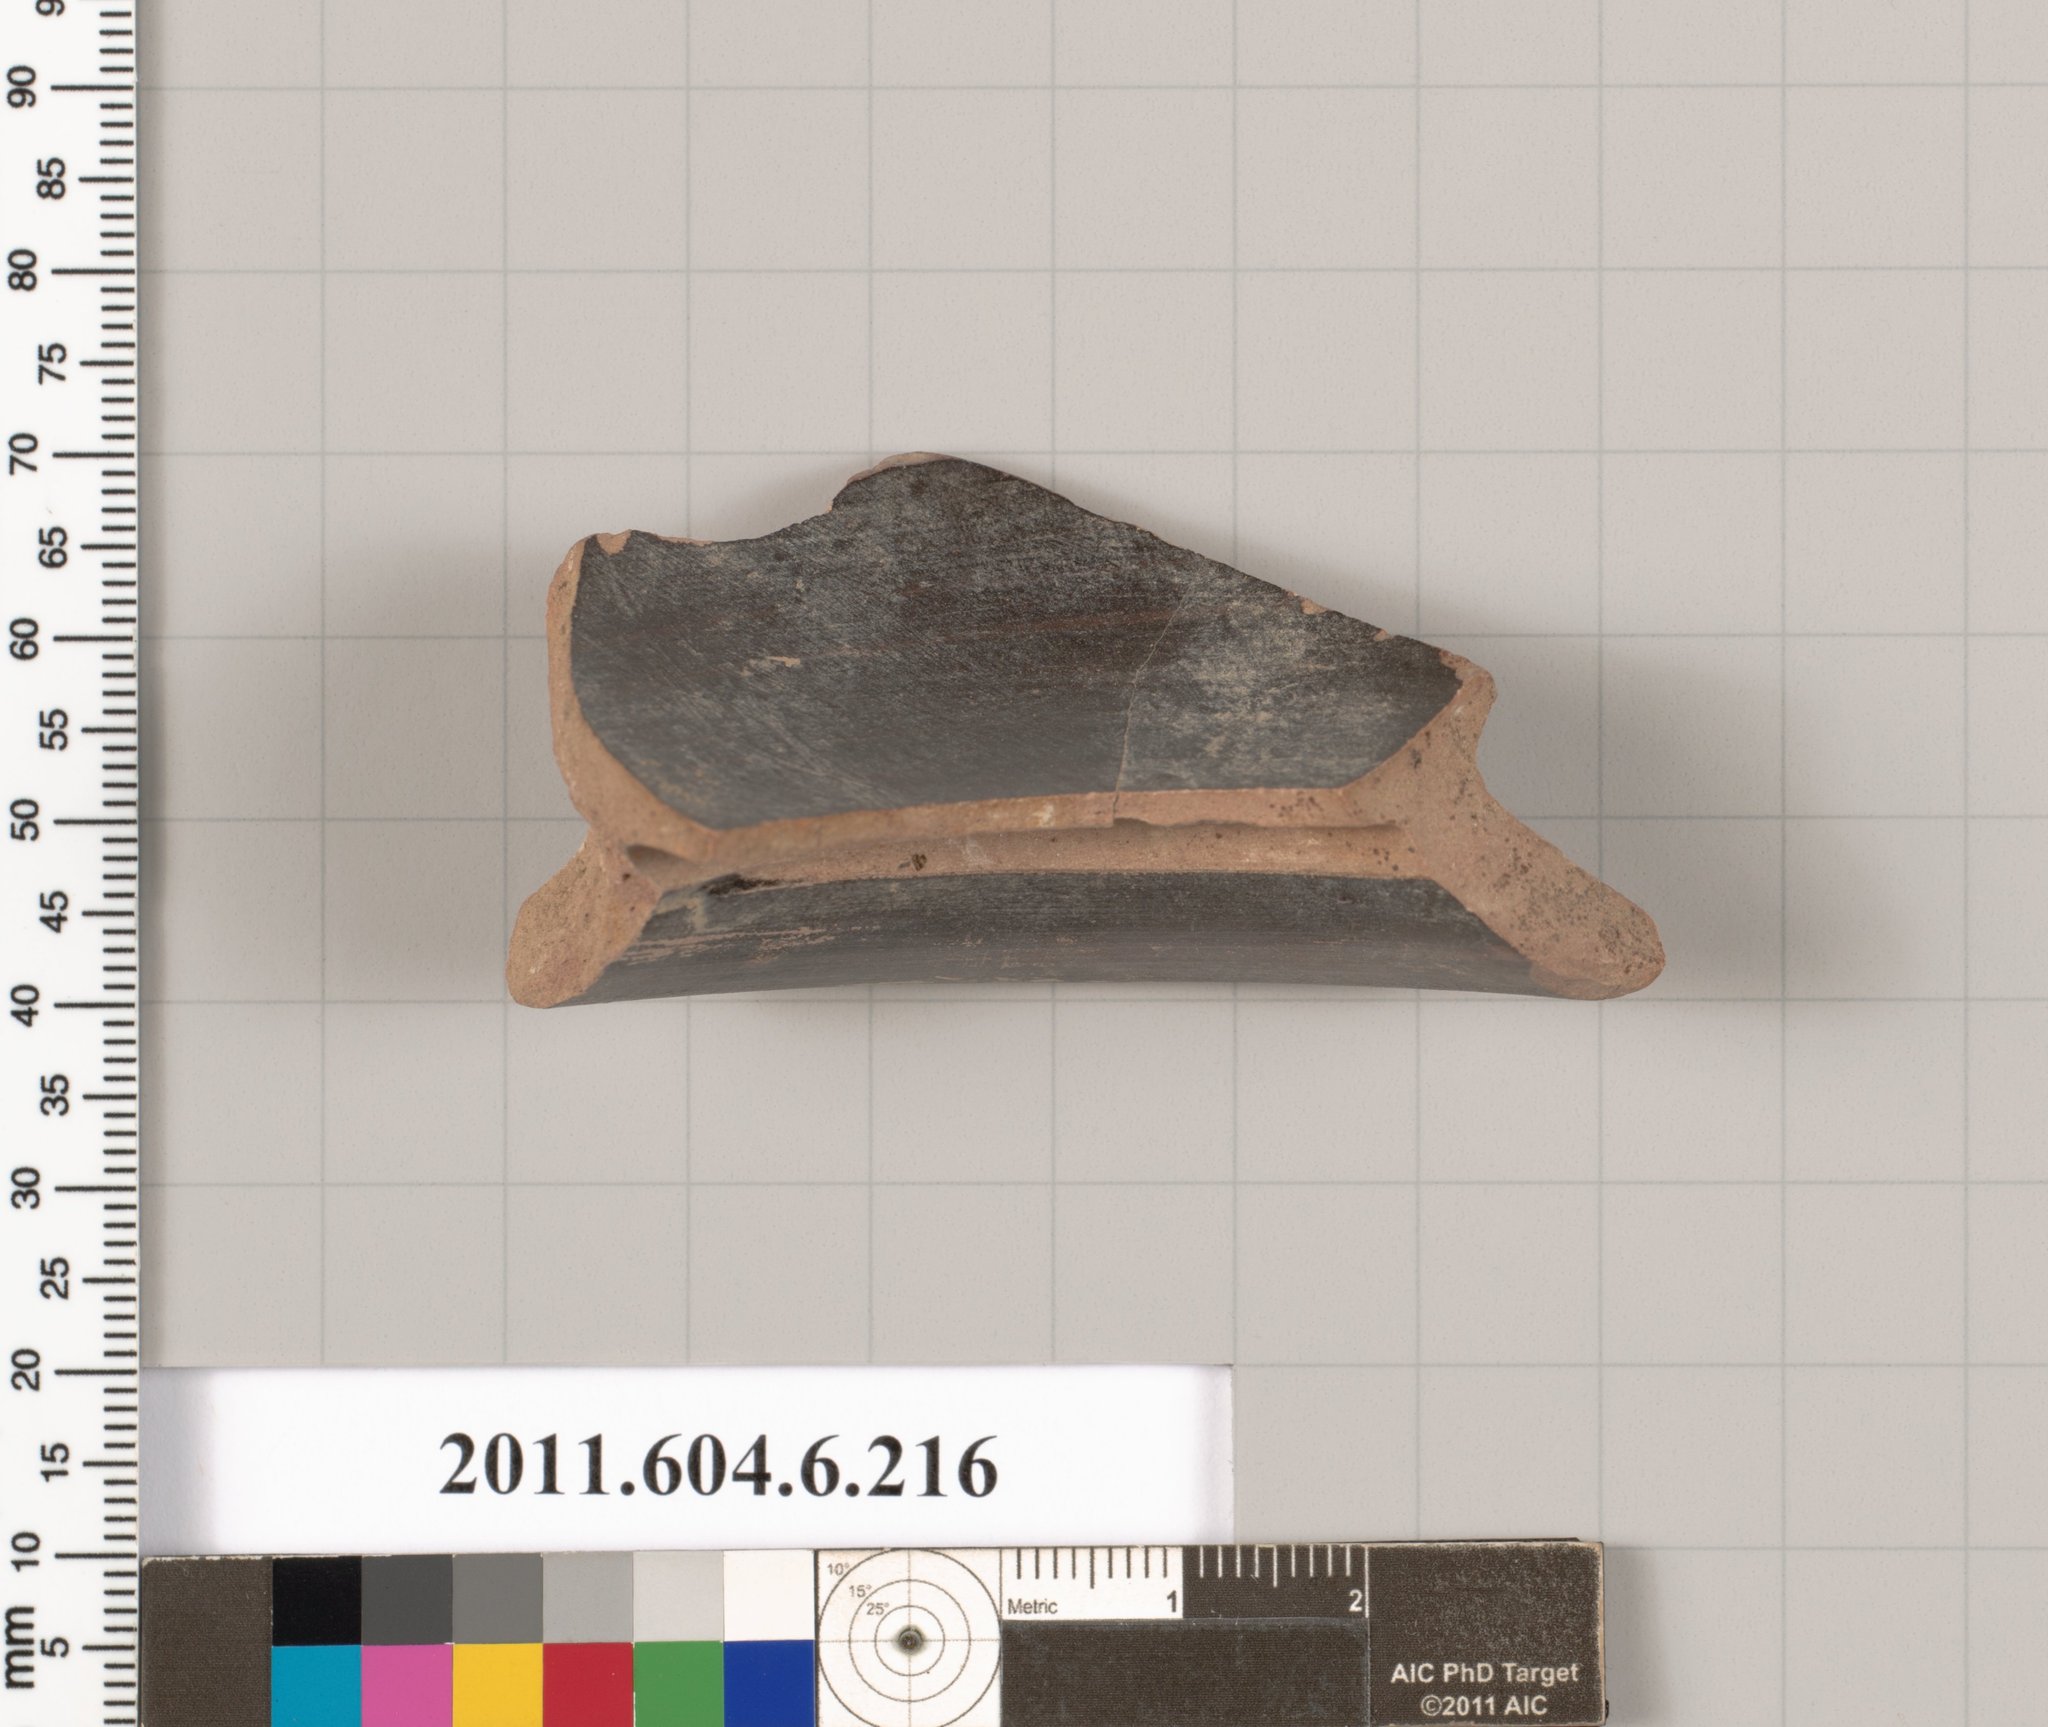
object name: undetermined open shape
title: Terracotta fragment of an open shape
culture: greek, attic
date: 600-401 BCE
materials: terracotta